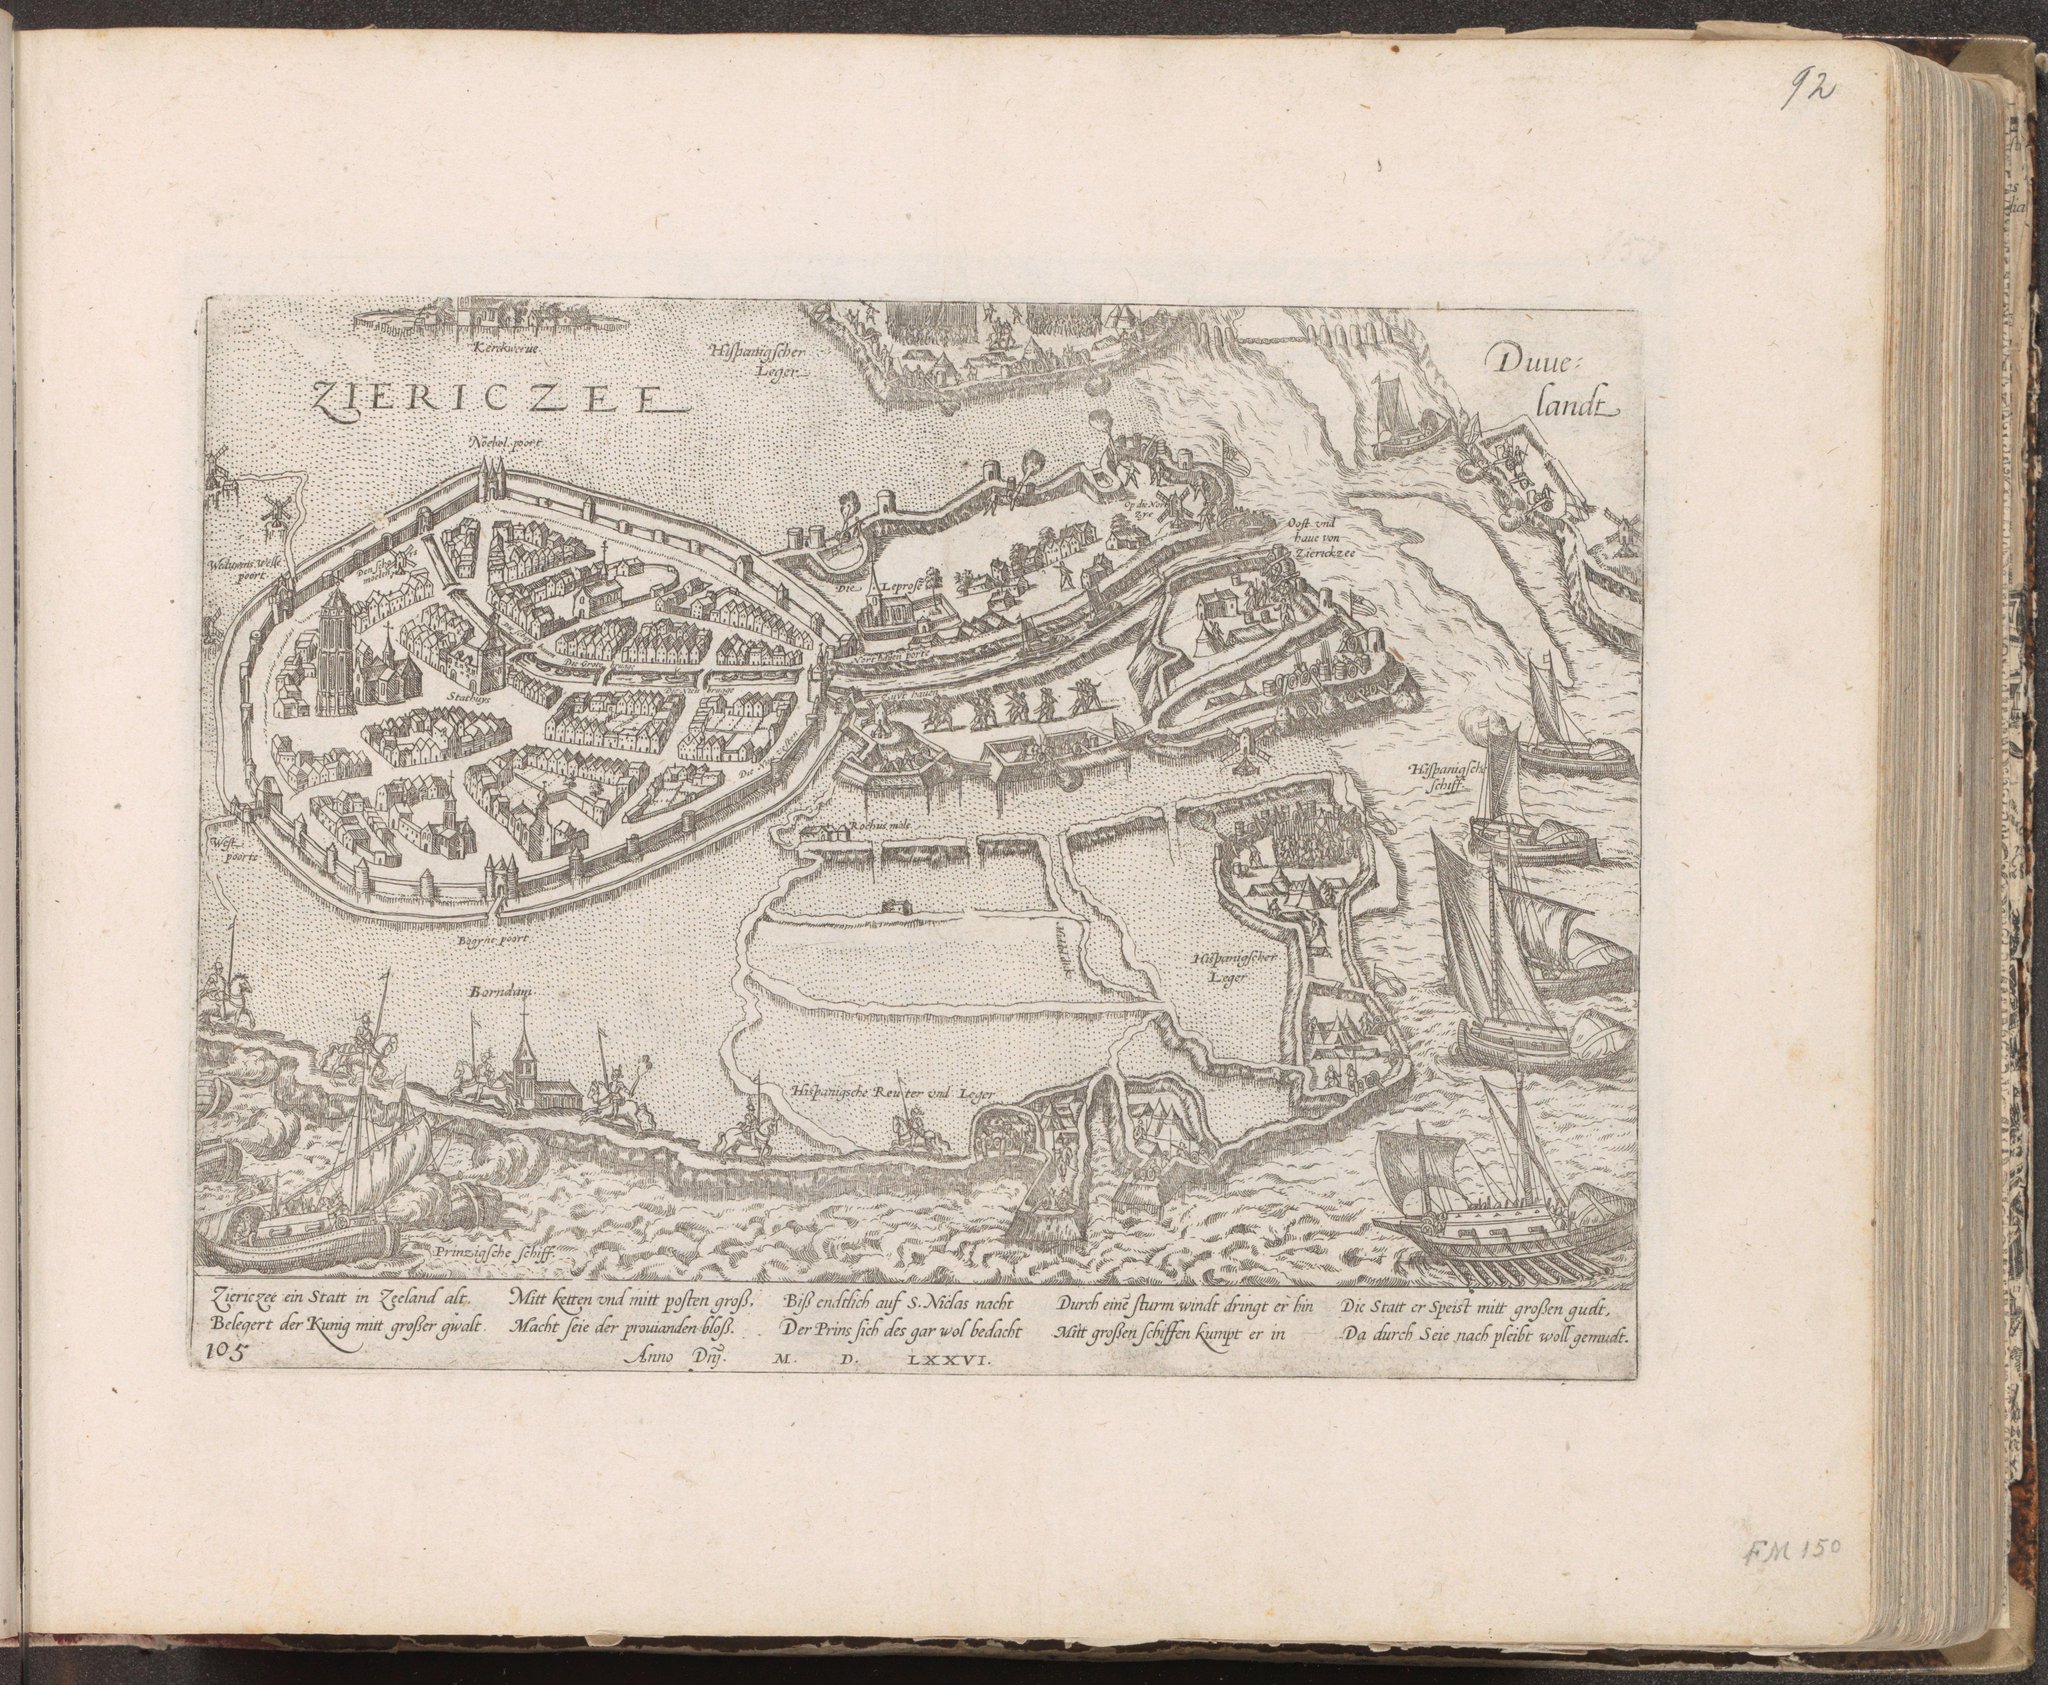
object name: album leaf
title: Serie 6: Nederlandse Gebeurtenissen, 1571-1576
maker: frans hogenberg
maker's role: print maker, publisher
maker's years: 1538-1590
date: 1576-1578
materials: paper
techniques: etching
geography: cologne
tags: antwerp, siege, position war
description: Beleg van Zierikzee door de Spanjaarden onder Mondragon. Ondanks een geslaagde poging van de schepen van de prins om de stad van proviand te voorzien geeft de stad zich over op 29 juni 1576. Gezicht op de ommuurde stad met de posities van de belegerende Spaanse troepen en de Spaanse schepen en de schepen van de prins. Met onderschrift van 10 regels in het Duits. Linksonder genummerd: 105. De prent maakt deel uit van een album.